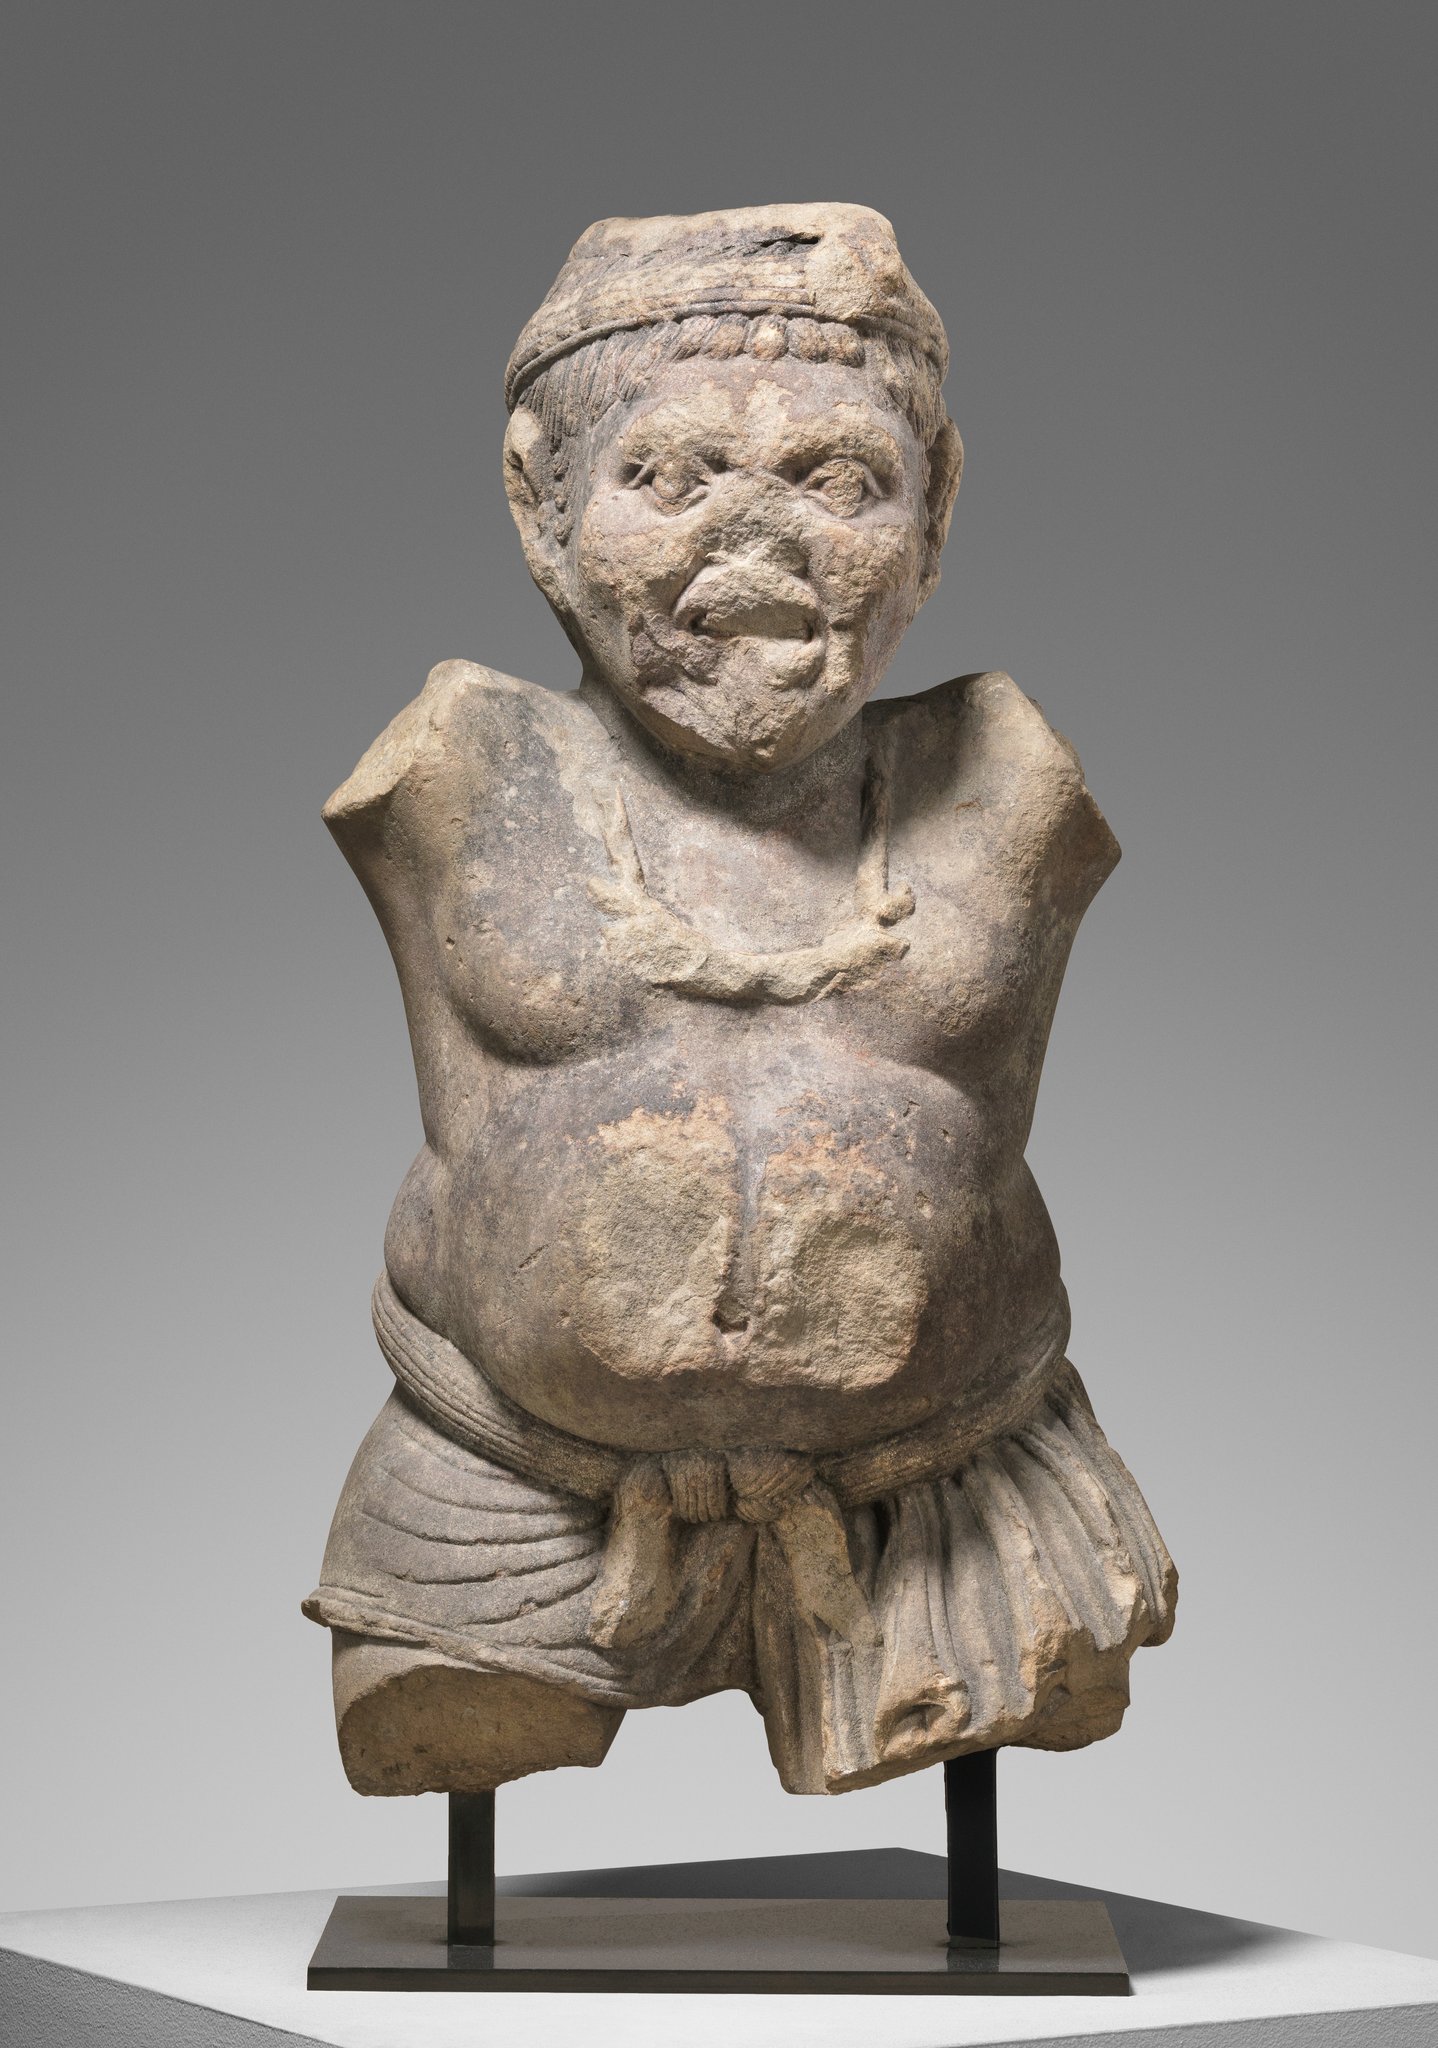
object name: yaksha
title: Patravahaka yaksha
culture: indian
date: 50 BCE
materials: stone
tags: shunga